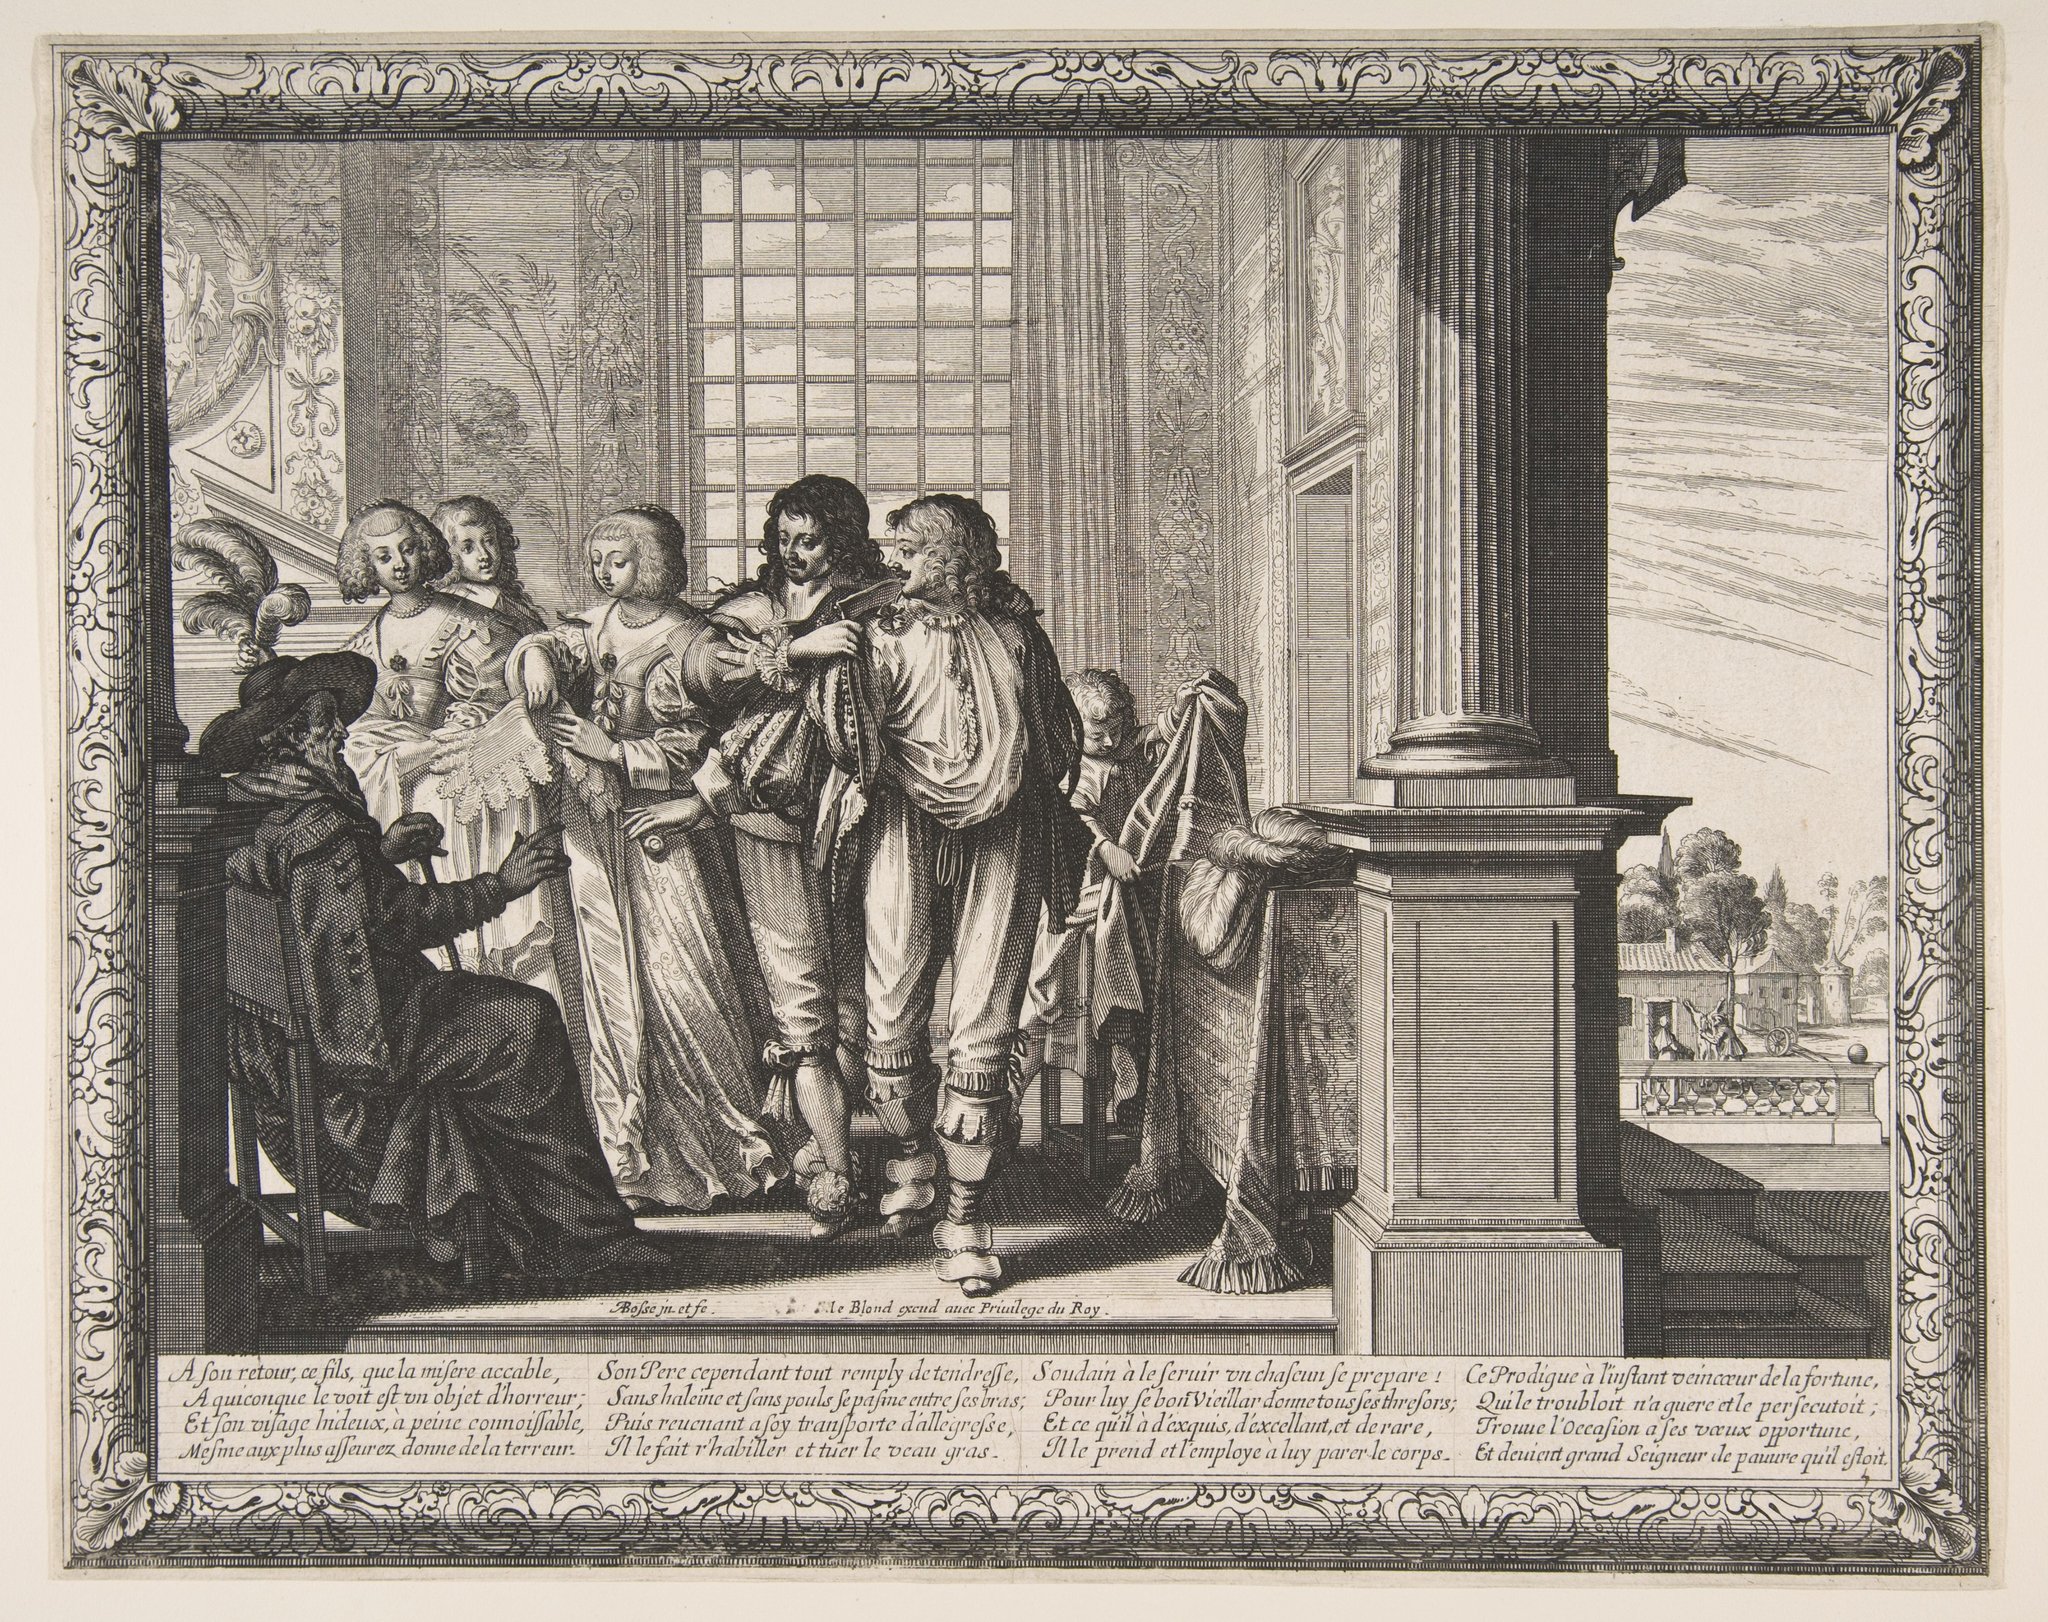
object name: print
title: The Prodigal Son Changes Clothes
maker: abraham bosse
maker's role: artist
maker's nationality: french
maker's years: 1602-1676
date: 1636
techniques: etching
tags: men,women